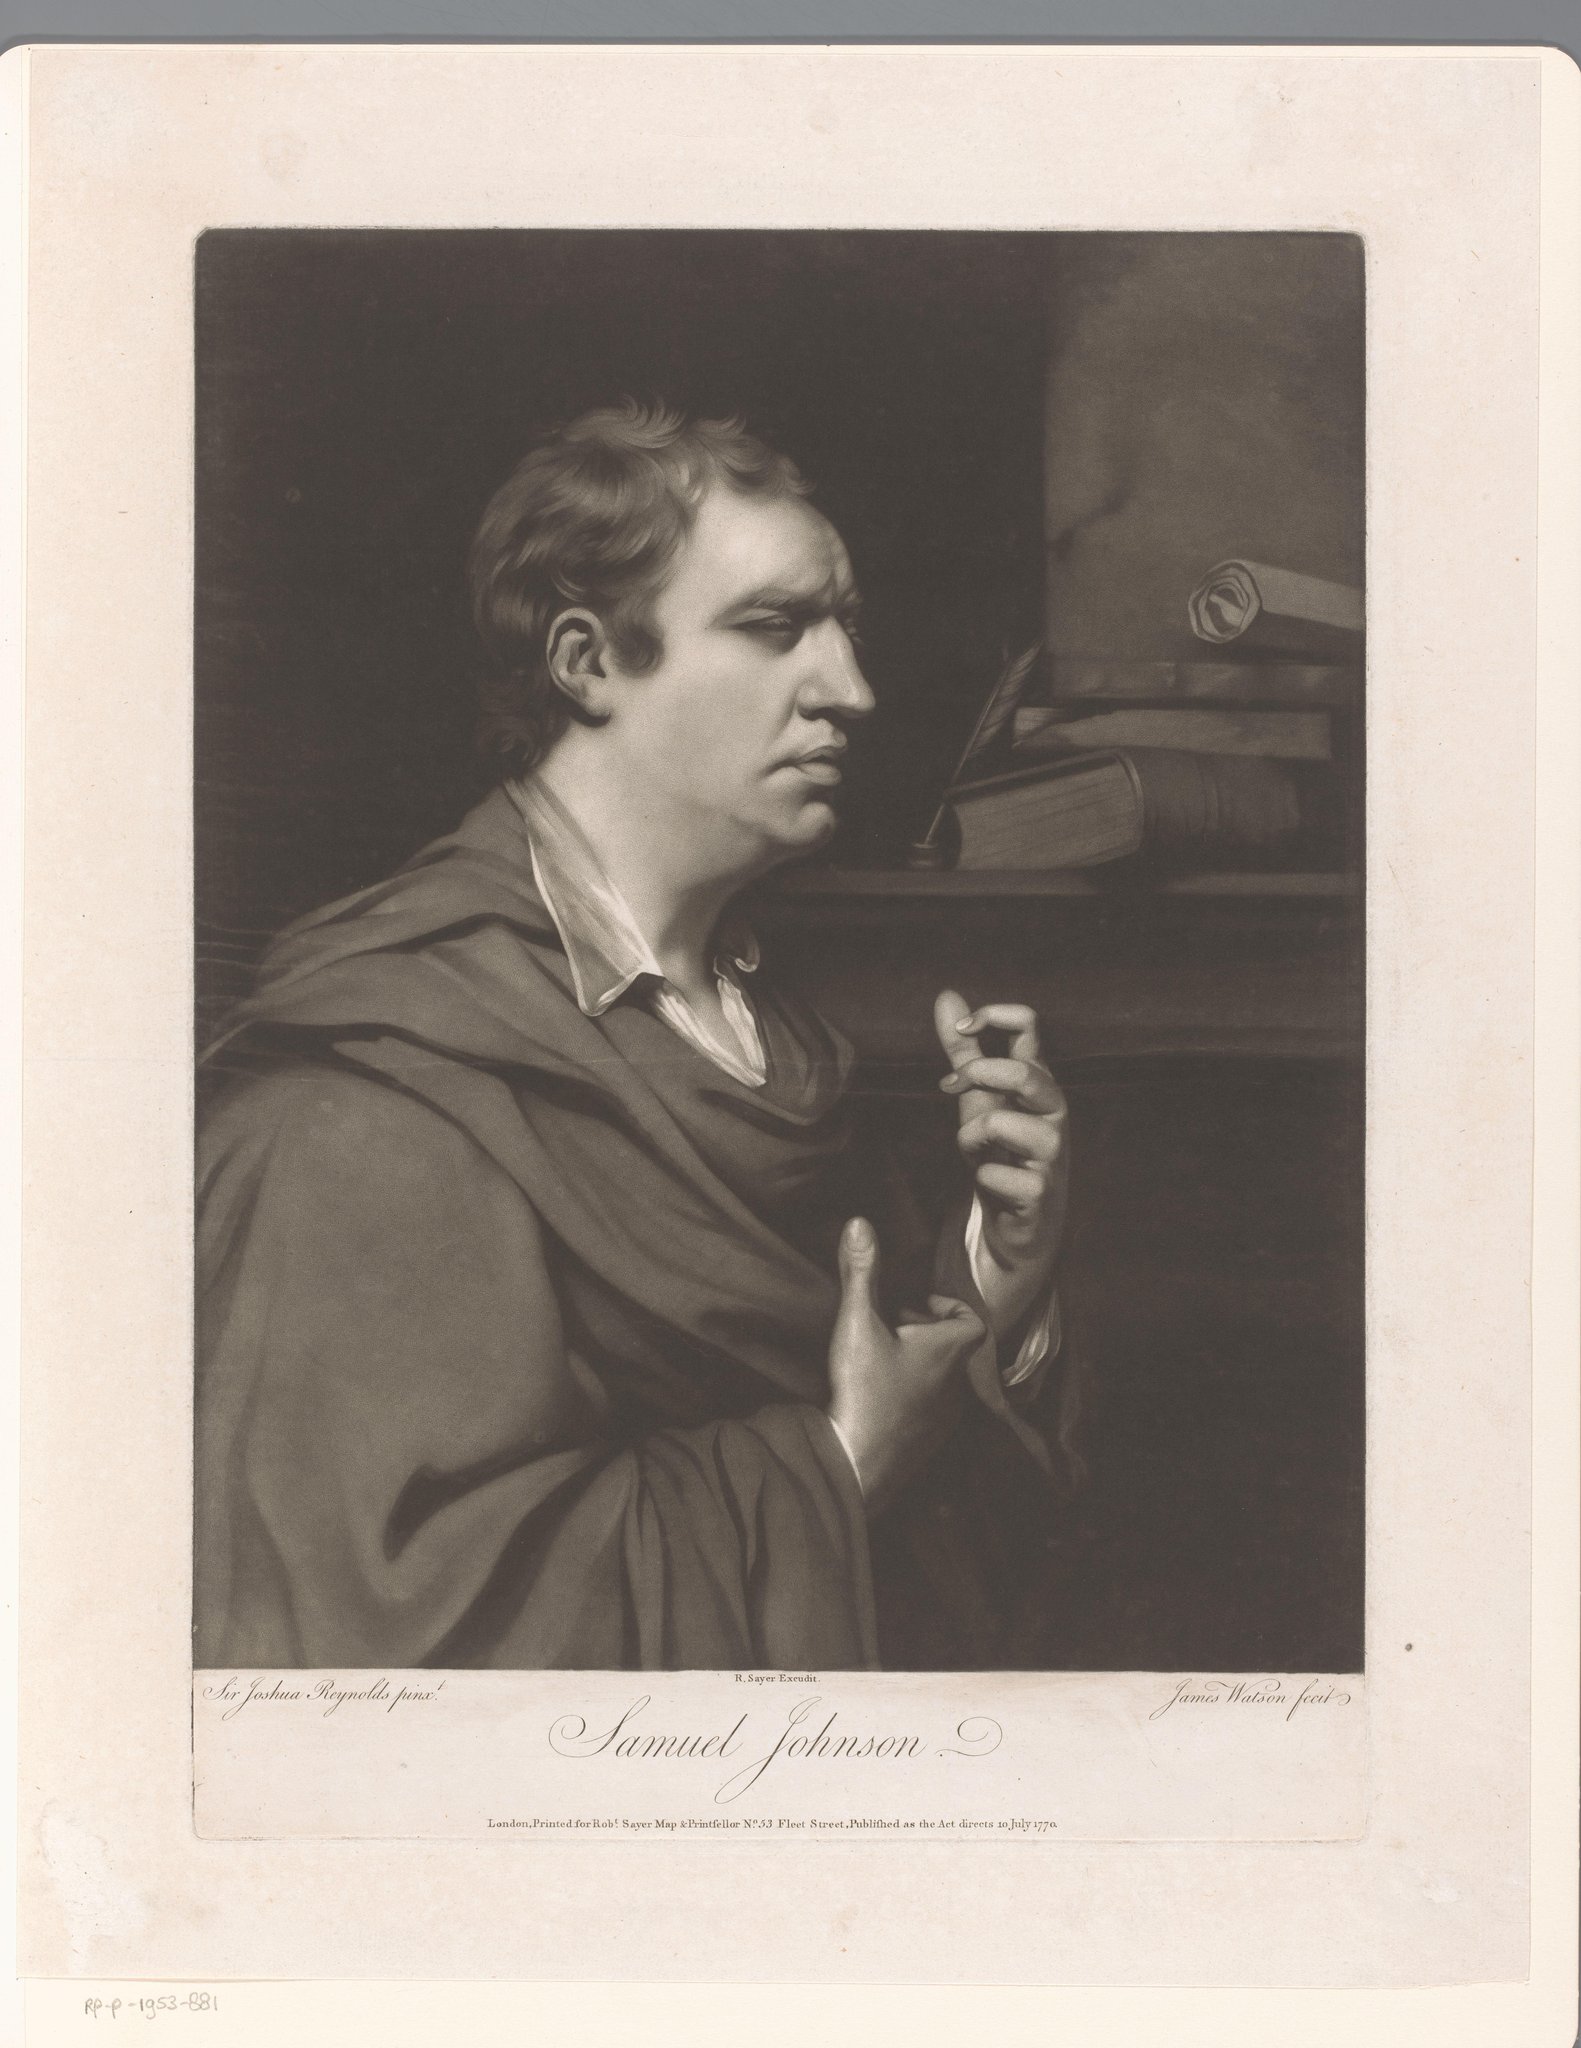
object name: print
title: Portret van Samuel Johnson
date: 1707-1770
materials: paper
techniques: mezzotint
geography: london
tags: historical persons, portrait of a writer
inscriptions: collector's mark: Lugt 2760, collector's mark: Lugt 2228